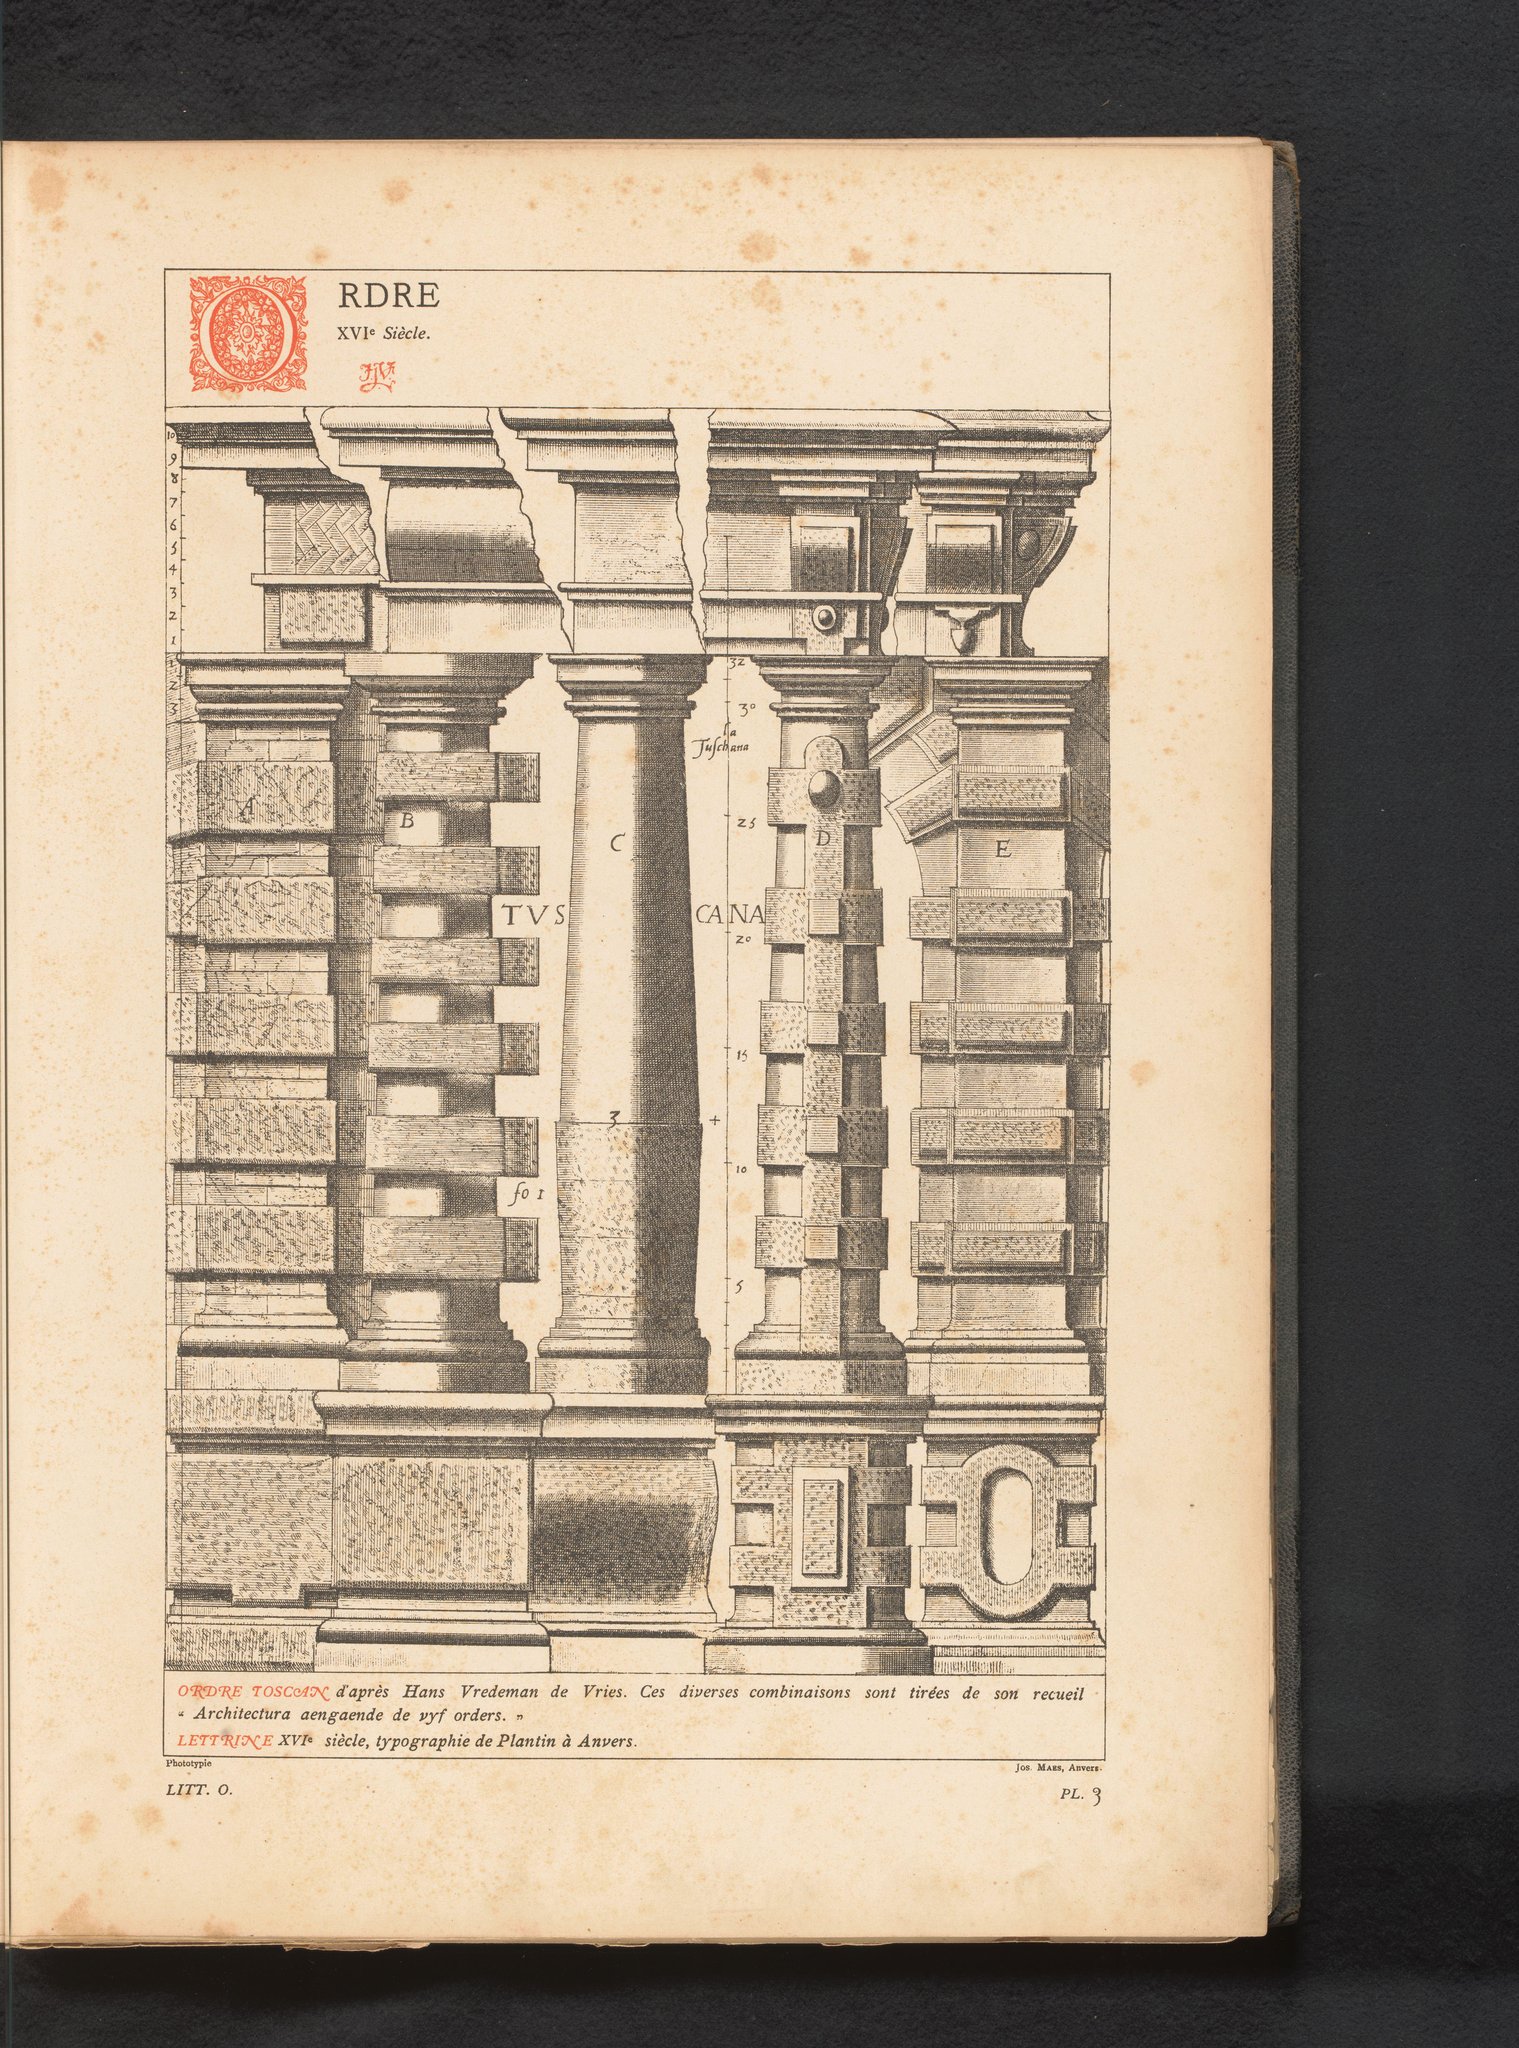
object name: photomechanical print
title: Ordre, XVI2 Siècle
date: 1876-1881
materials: paper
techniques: photolithography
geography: antwerp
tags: capital (~ column, pillar)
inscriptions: inscription: ‘LITT. O. - PL. 3’, inscription: ‘ORDE Toscan d'après (...)’, monogram: ‘JJvY’